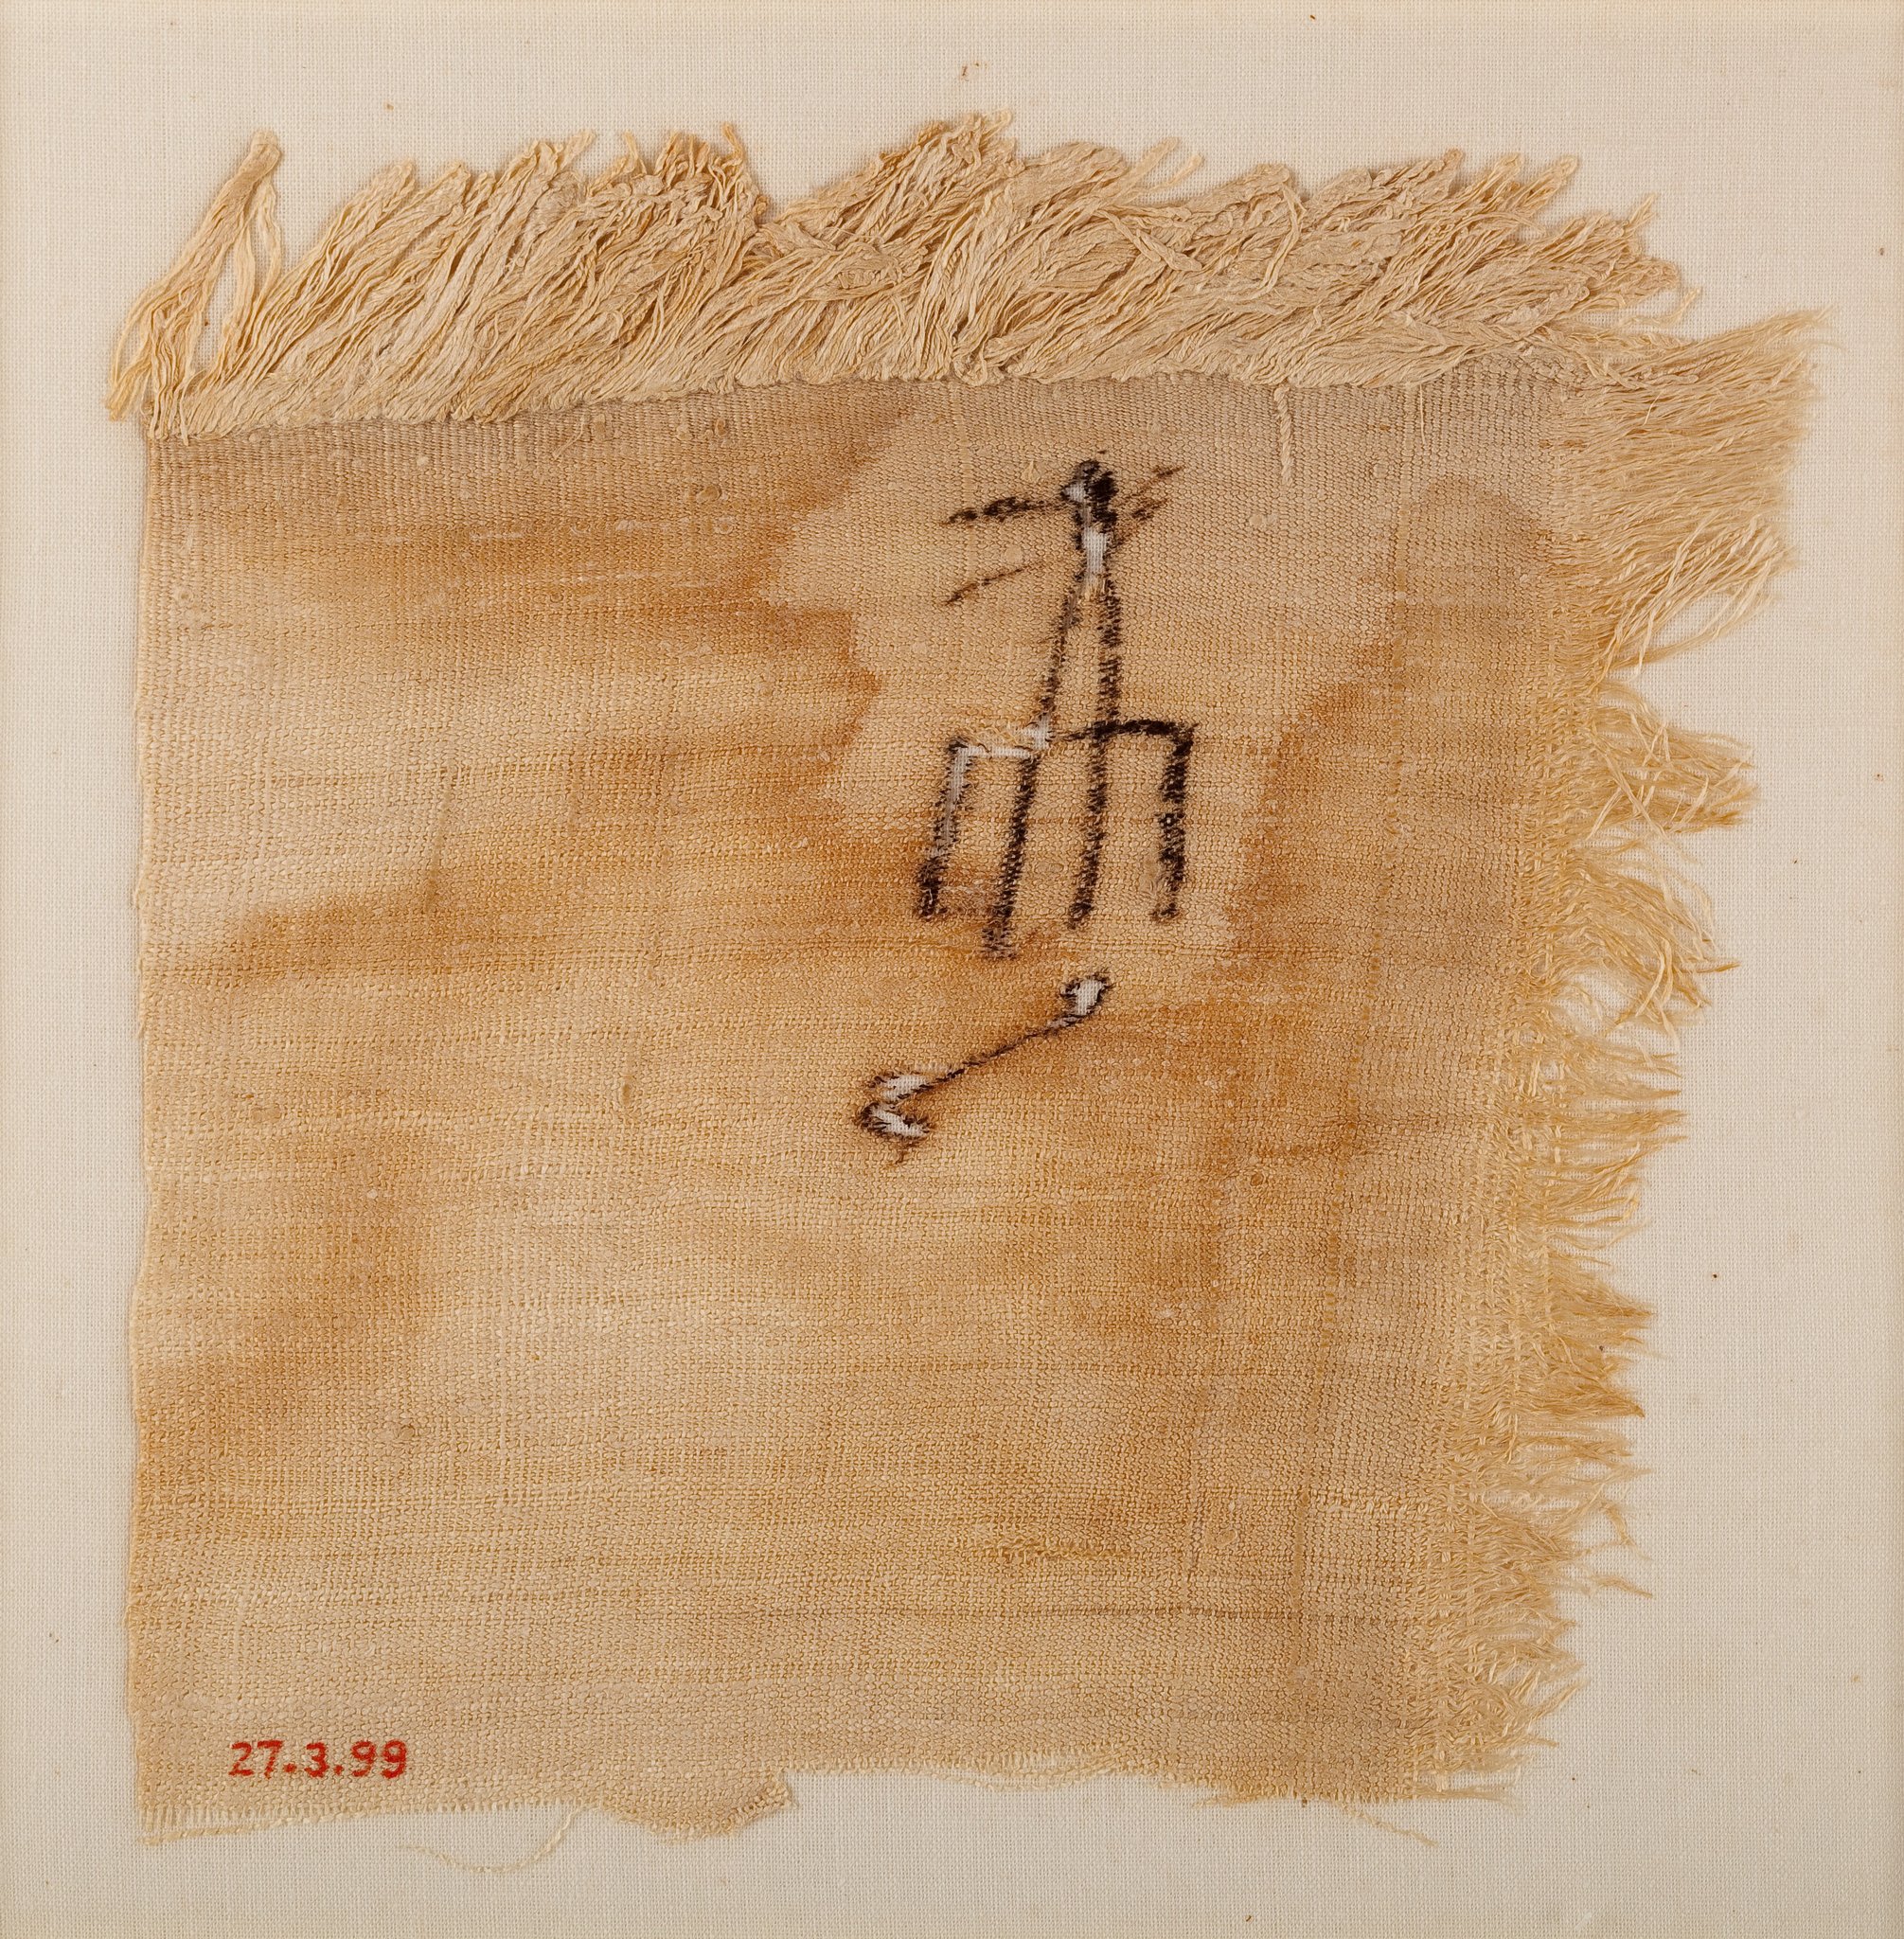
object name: linen mark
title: Linen mark (Type V)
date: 1961-1917 BCE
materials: linen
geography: egypt